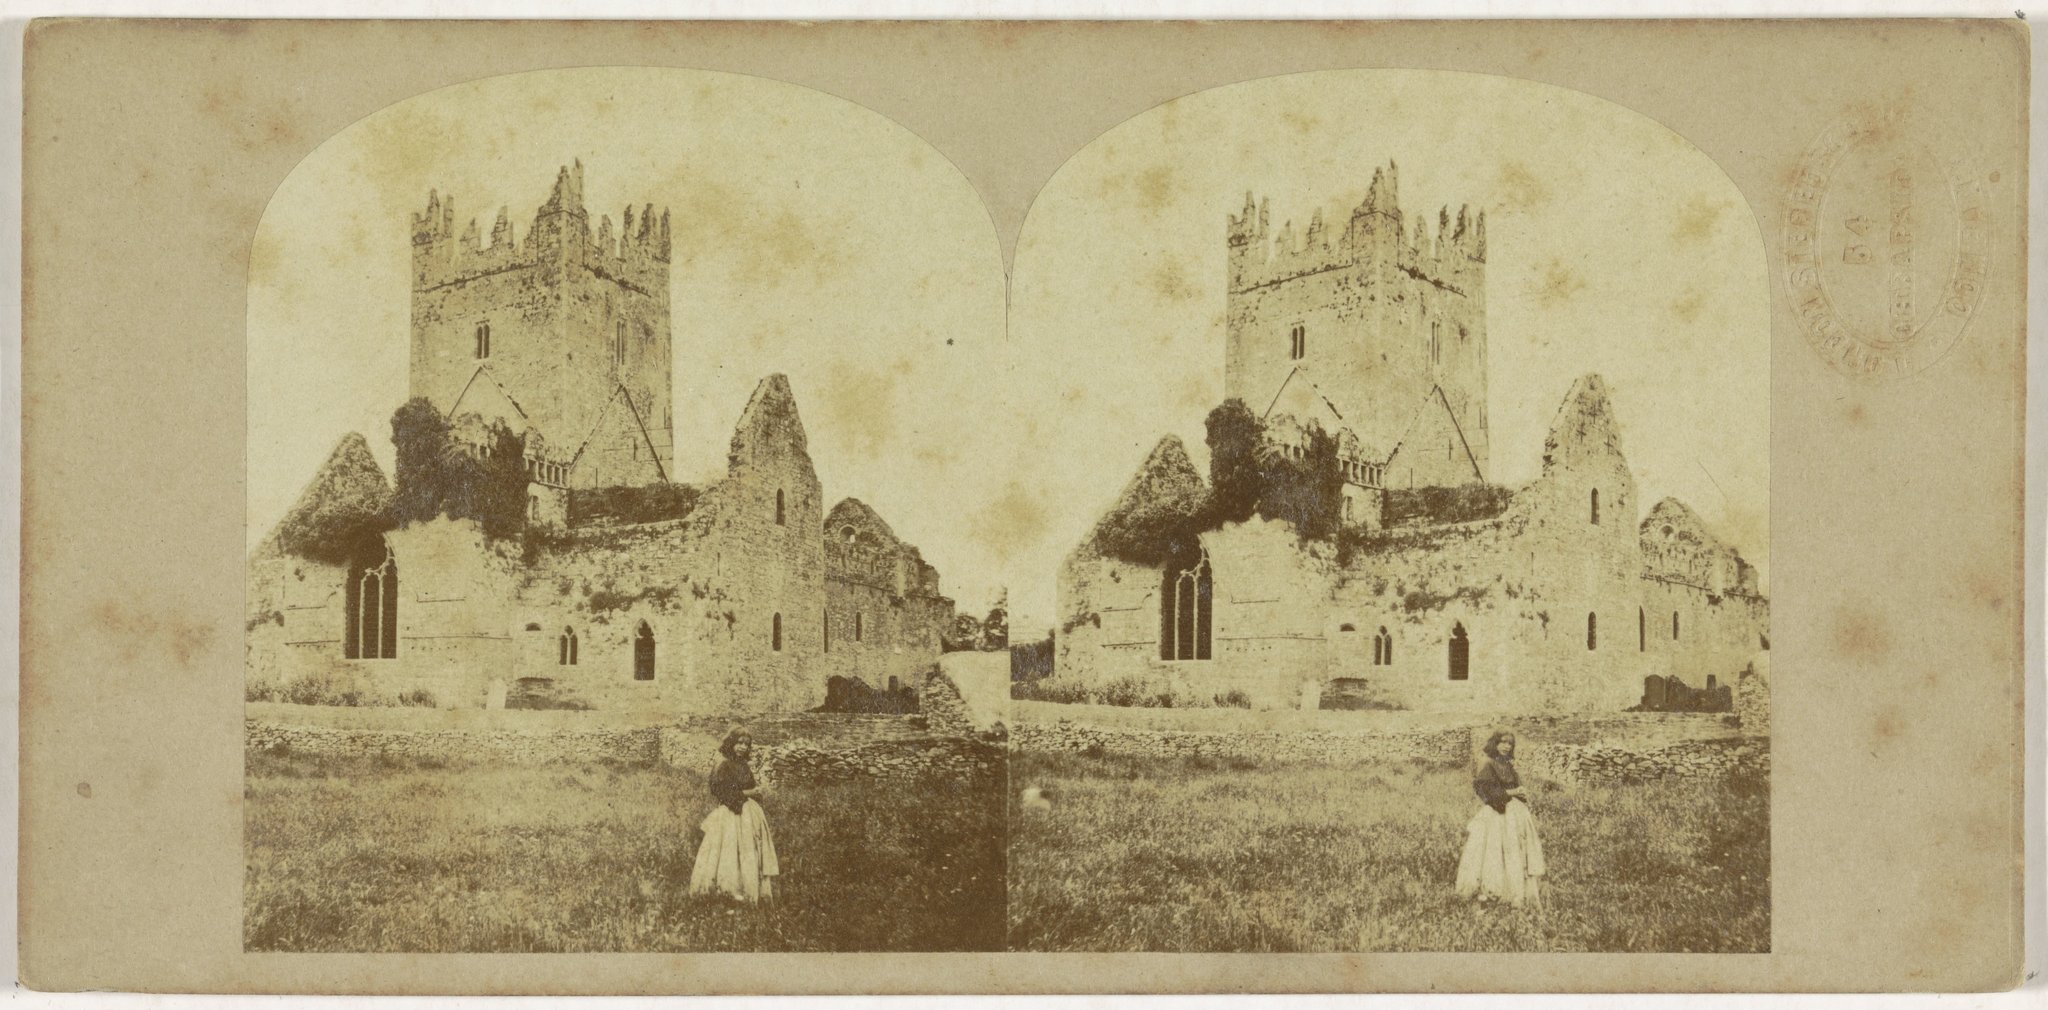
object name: stereograph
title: Abdij van Jerpoint, Ierland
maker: Anonymous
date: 1856-1922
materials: cardboard, paper, photographic support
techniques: albumen print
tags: ierland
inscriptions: name: ‘H. Ameschot.’, label: ‘Jerpoint Abbey, Is about eleven miles south of Kilkenny, on the River Nore.....’, inscription: ‘N.° 11.’, check stamp: ‘London Stereoscopic Company / 54 Cheapside’